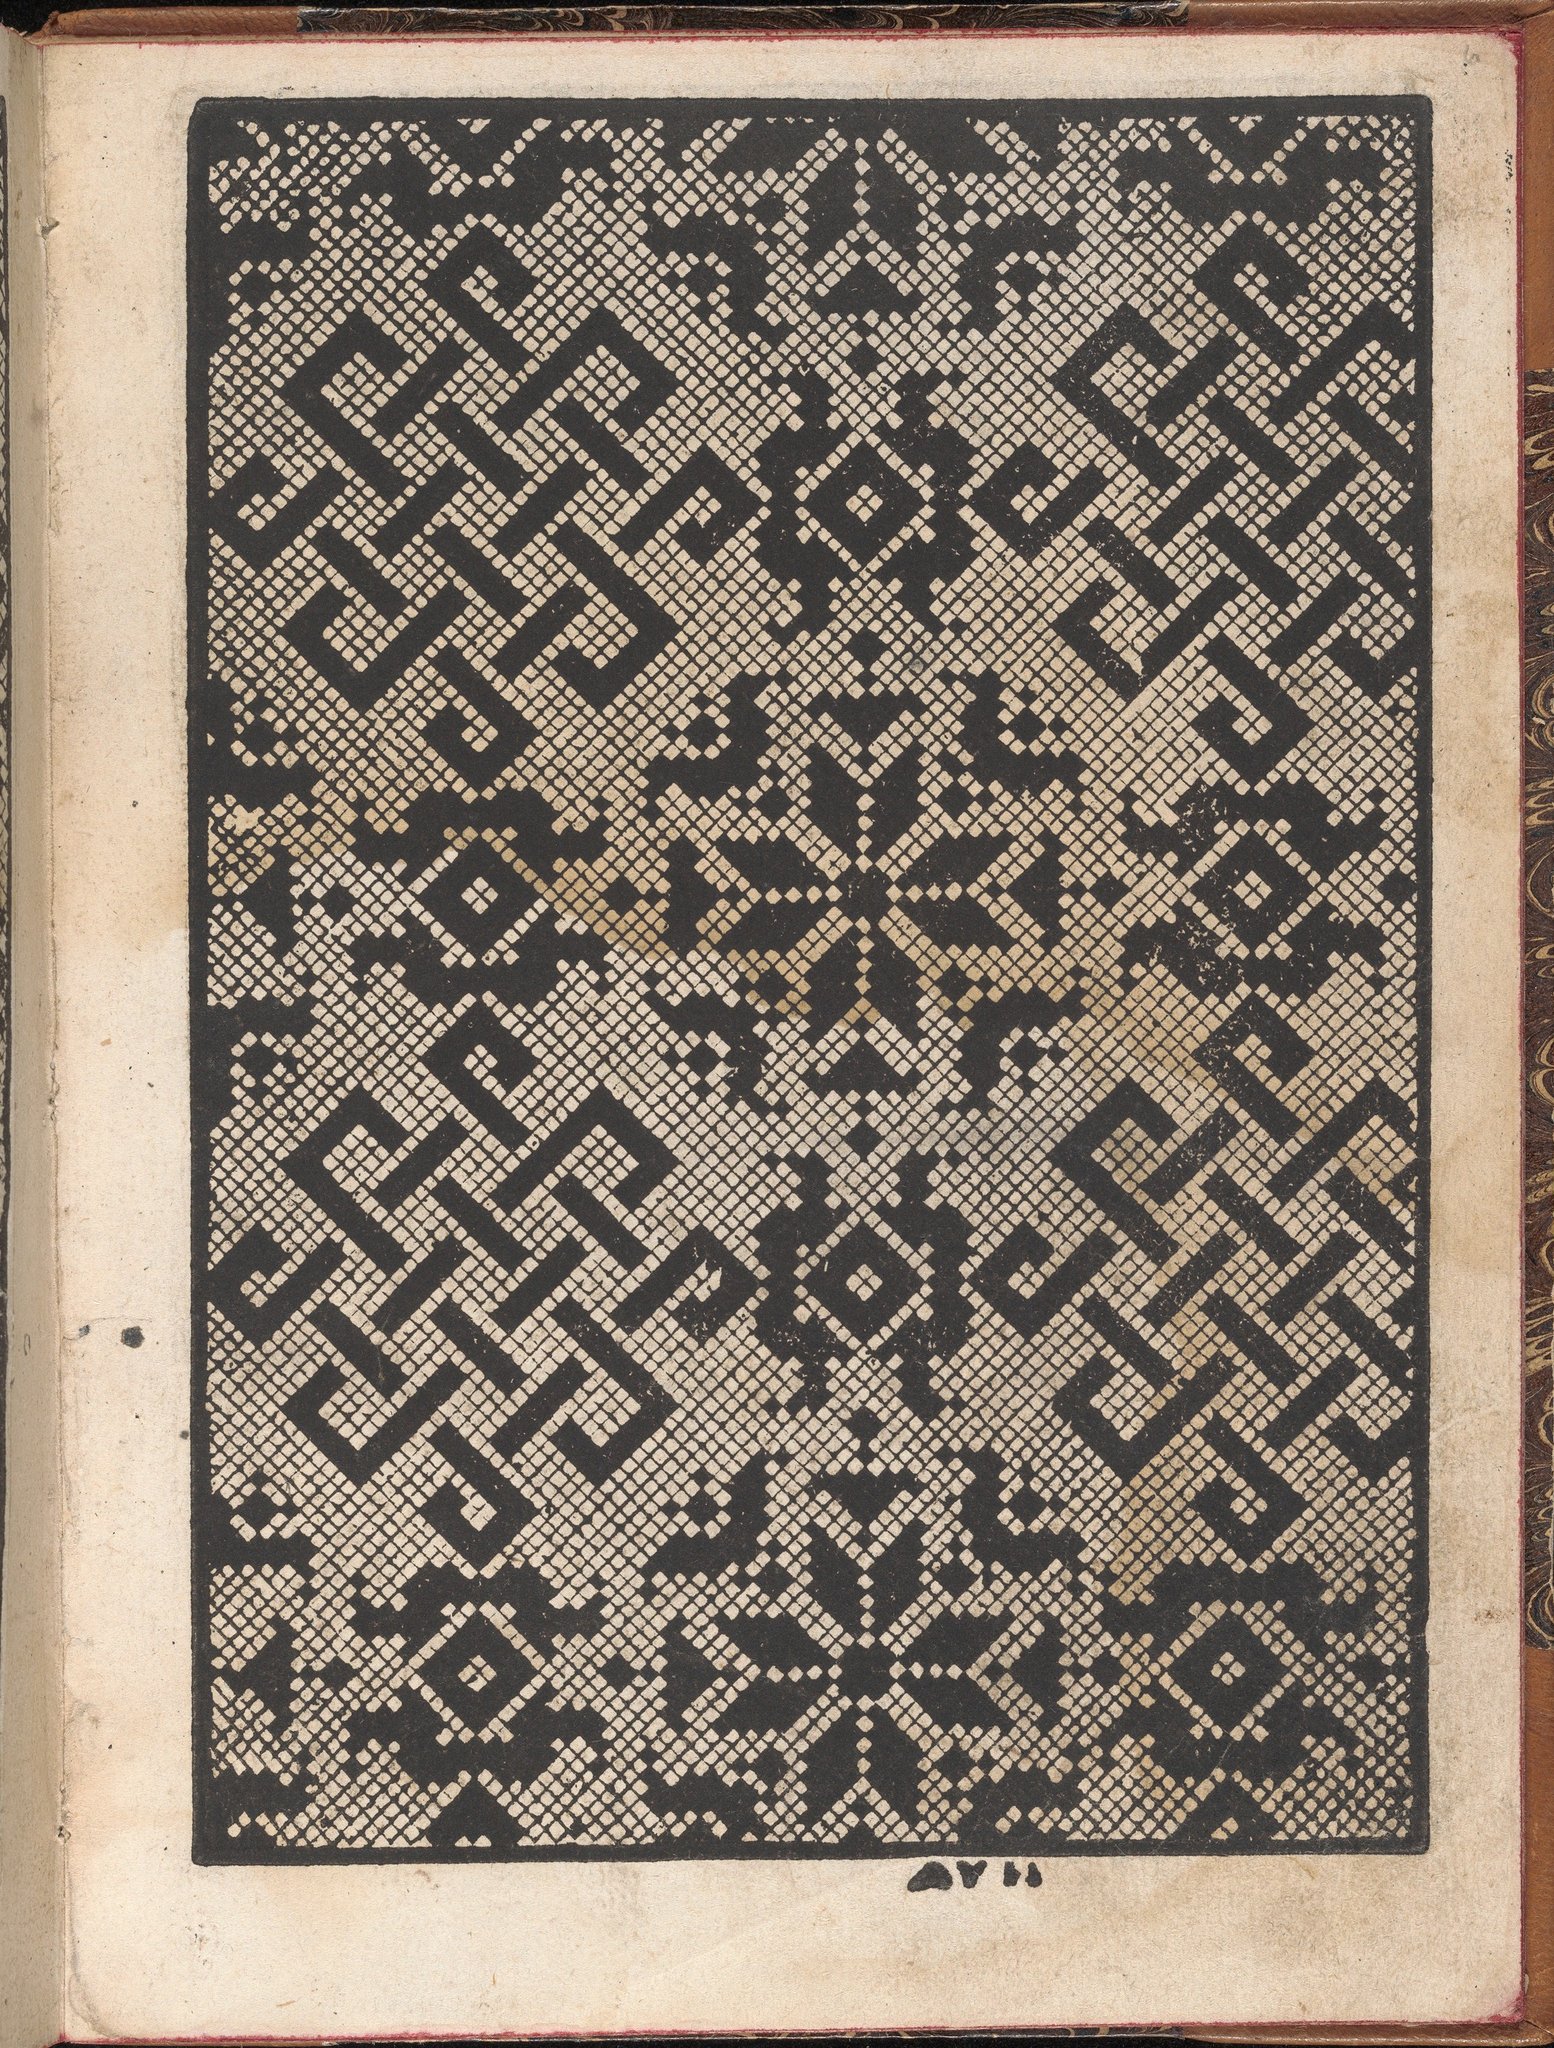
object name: book print ornament architecture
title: Spechio di pensieri delle belle et Virtudiose donne, page 6 (recto)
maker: matteo pagano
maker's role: publisher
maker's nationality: italian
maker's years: 1515-1588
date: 1546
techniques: woodcut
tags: ornament